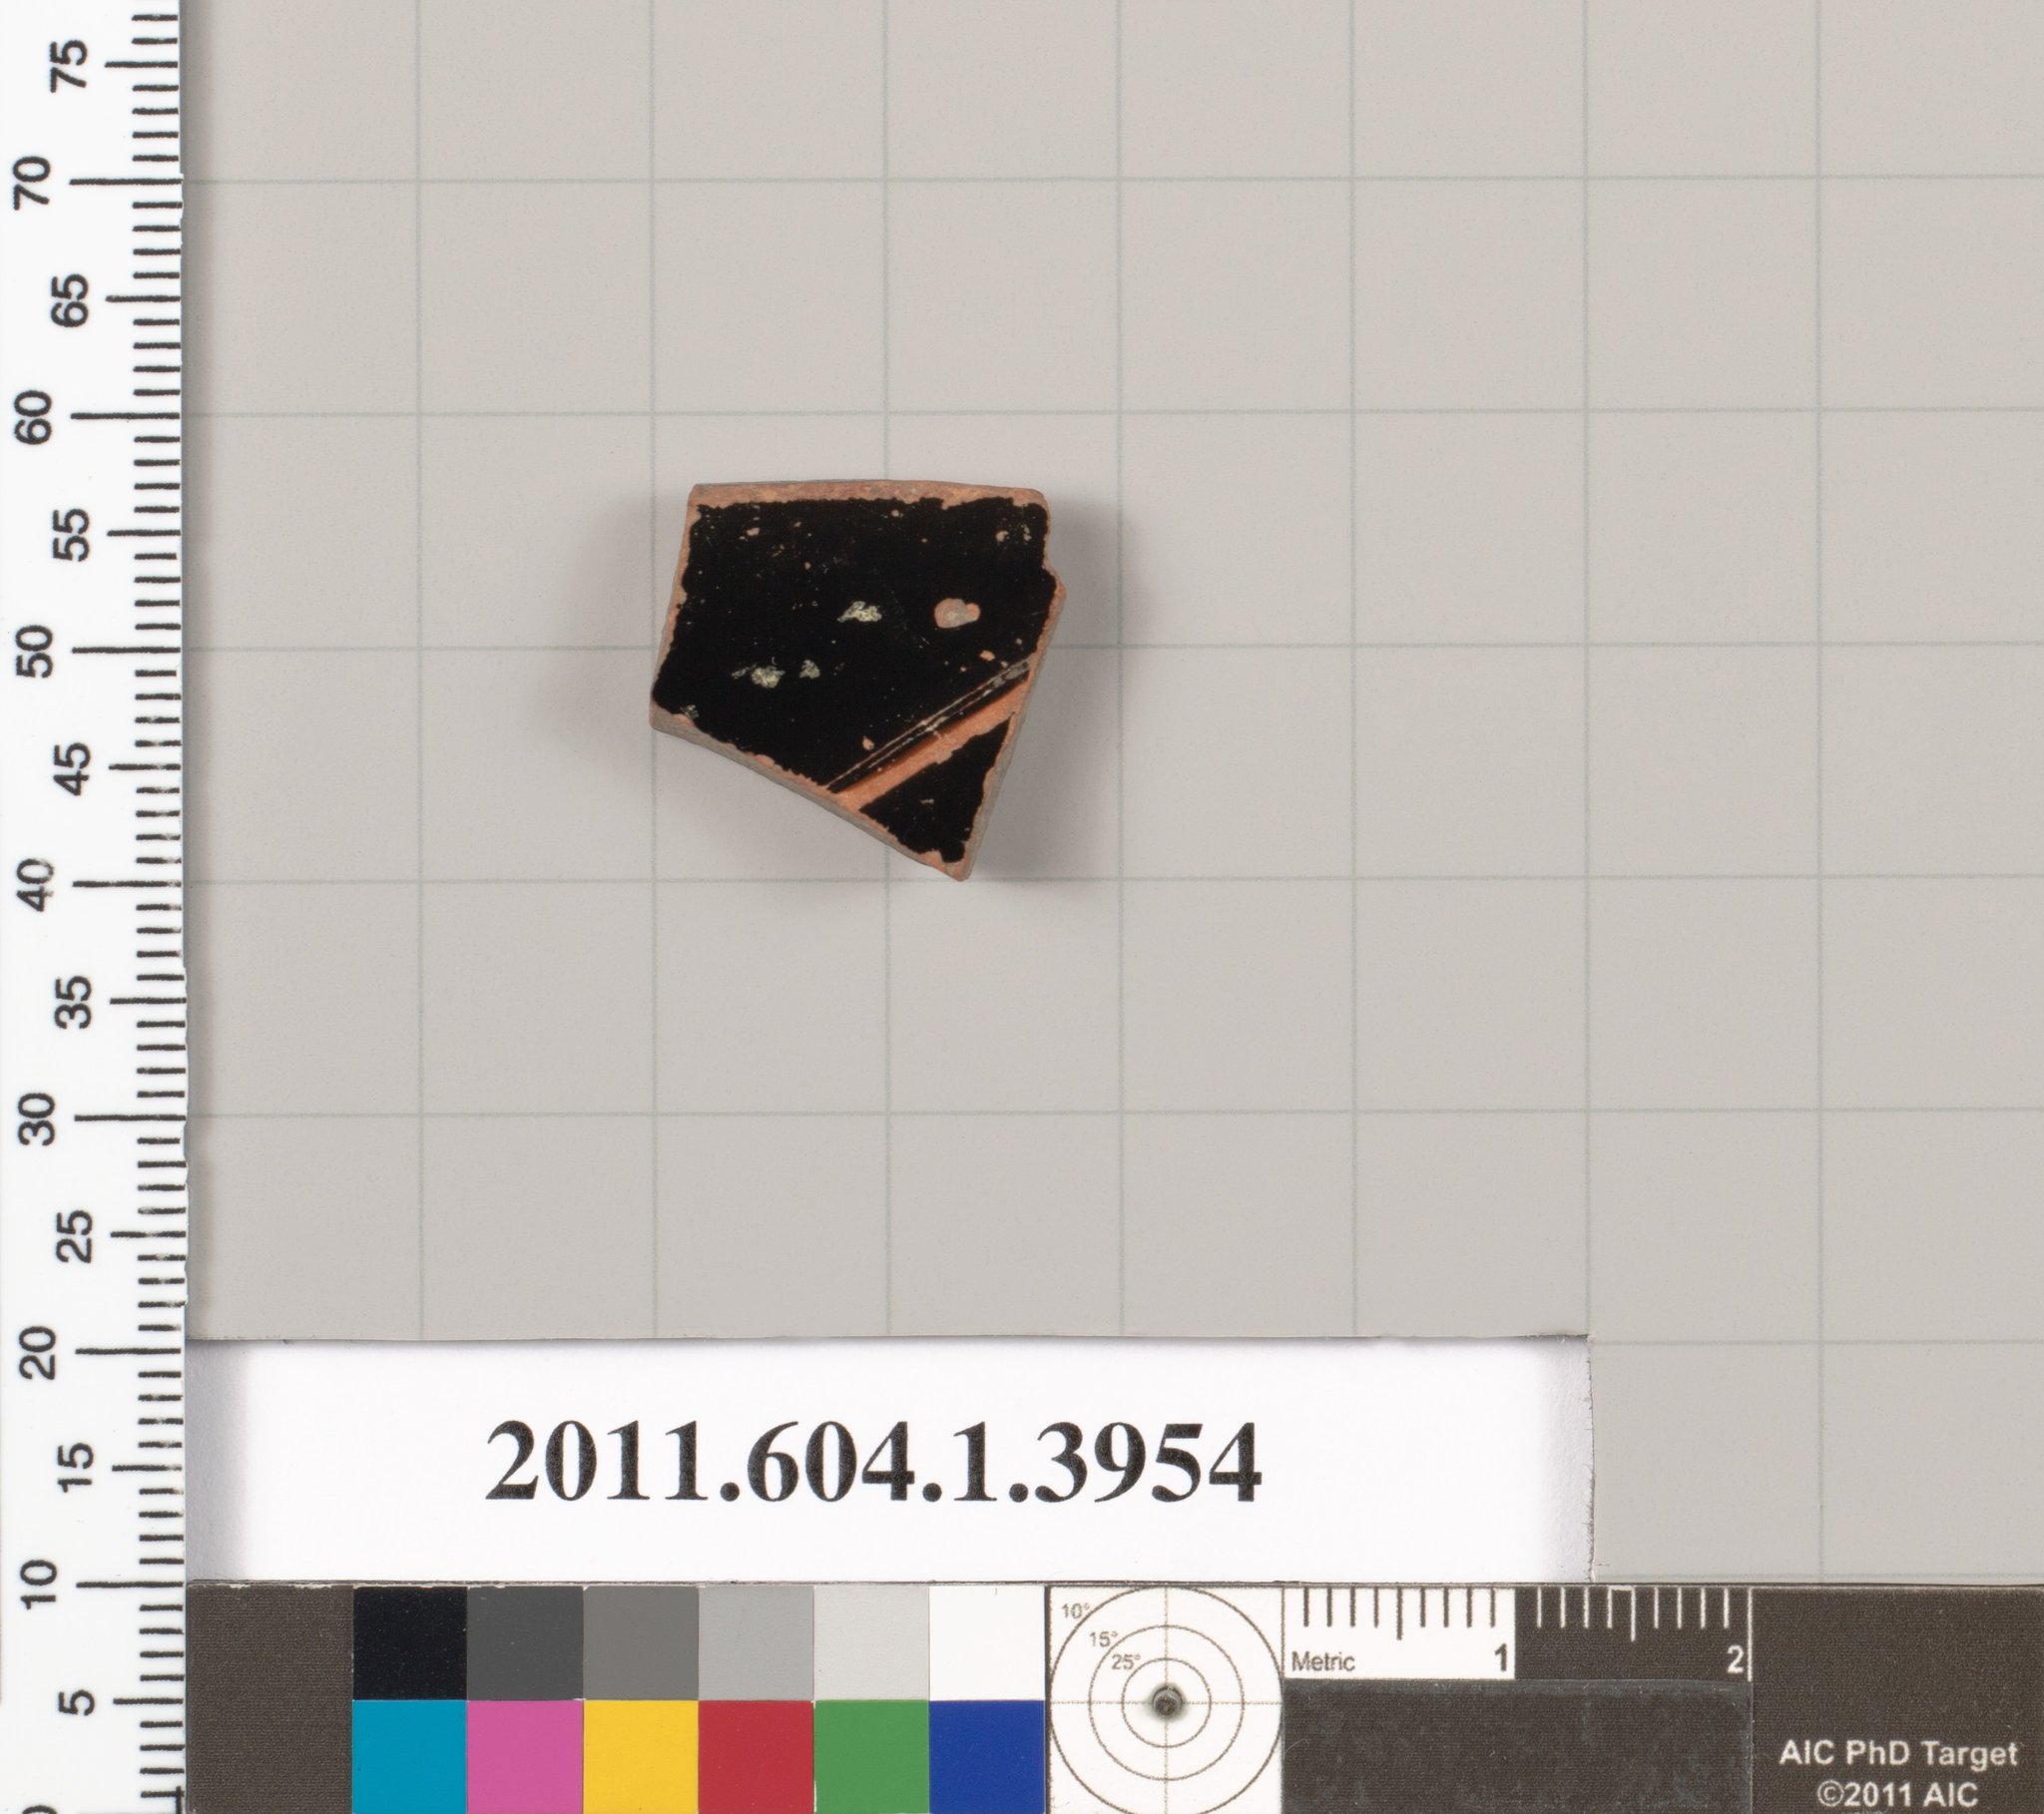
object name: kylix fragment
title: Terracotta rim fragment of a kylix (drinking cup)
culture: greek, attic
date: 475-451 BCE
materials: terracotta